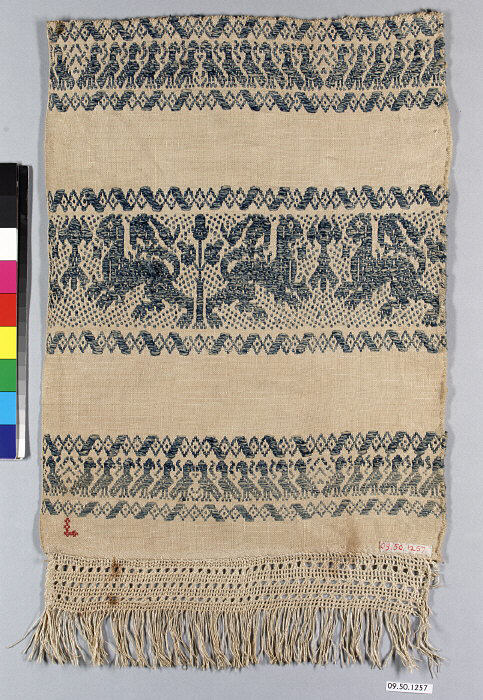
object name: piece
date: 1501-1700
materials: cotton, linen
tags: birds